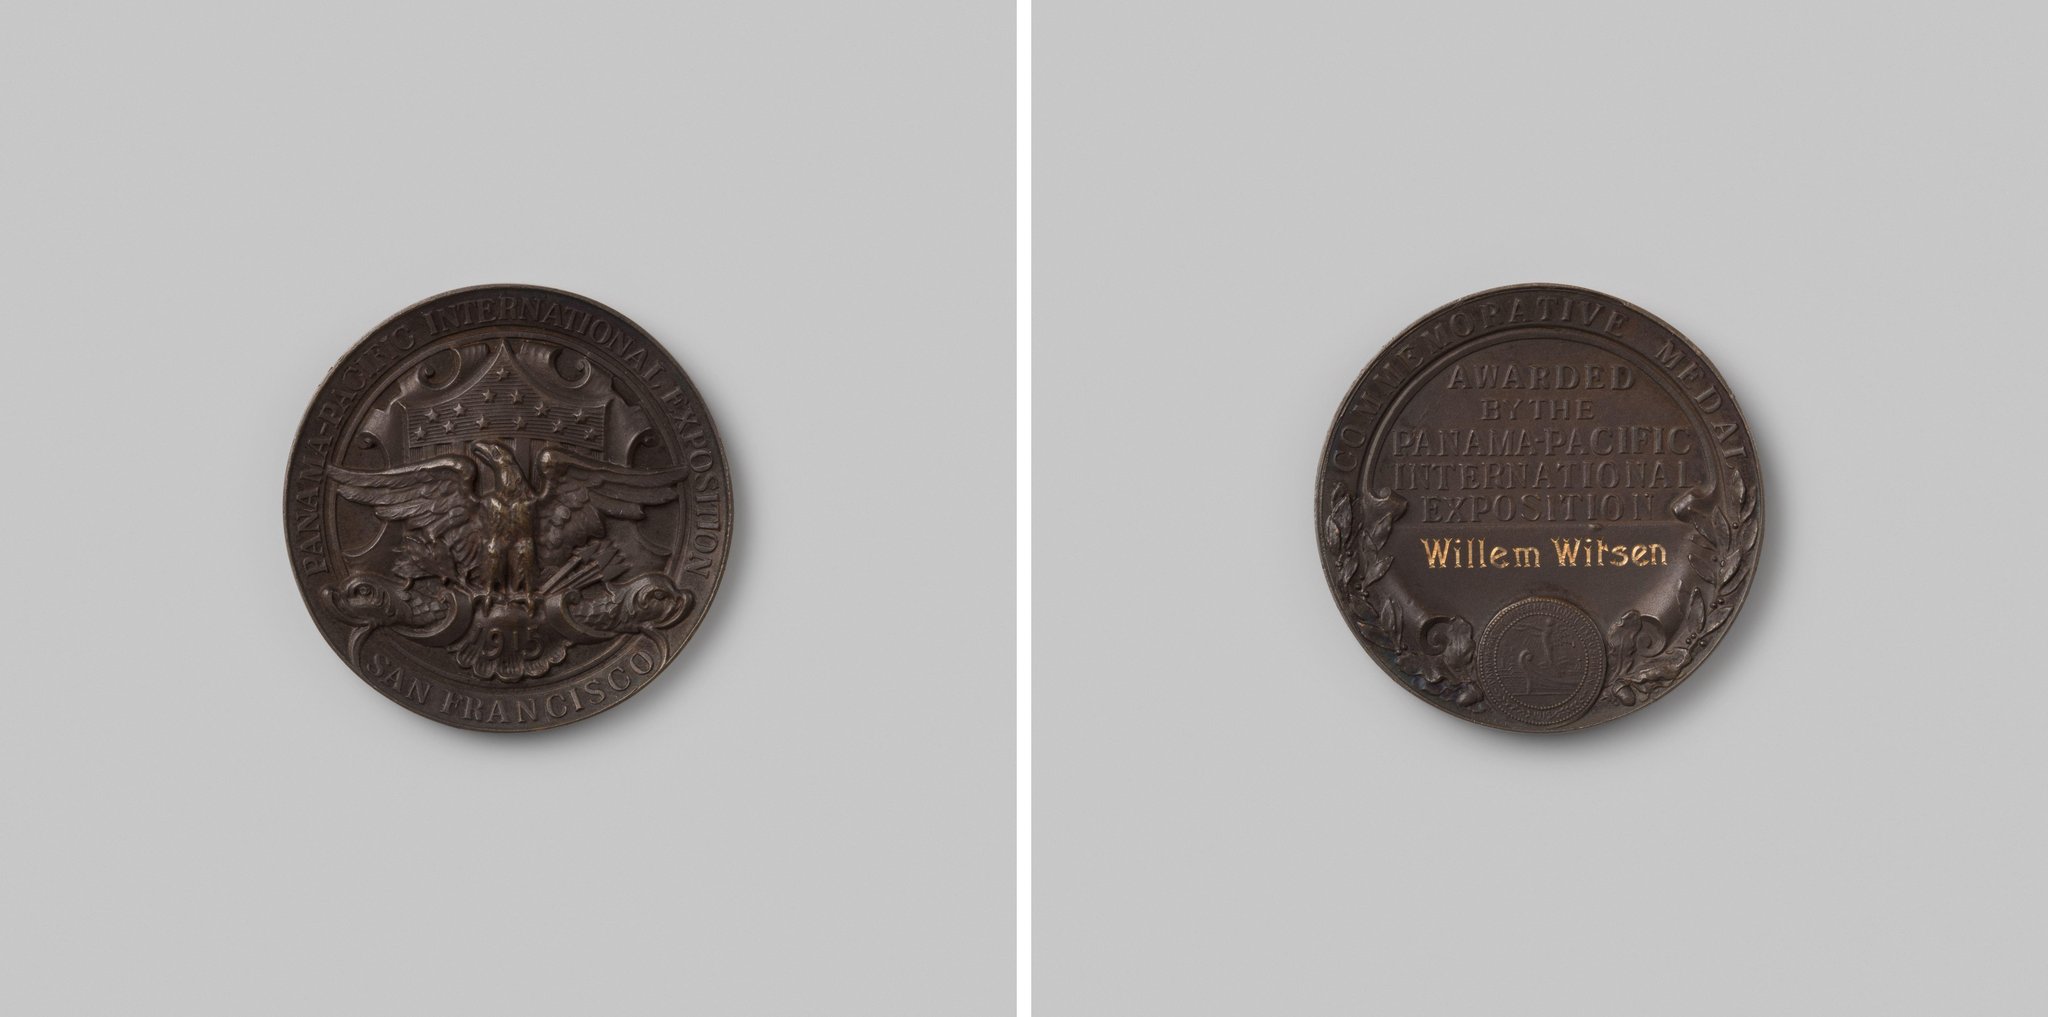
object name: medal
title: Panama-Pacific International Exposition te San Francisco, penning uitgereikt aan Willem Witsen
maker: Anonymous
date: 1915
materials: bronze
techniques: engraving, gilding, striking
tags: amsterdam, painter, print maker, draughtsman, willem witsen, world fair, world exhibition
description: Bronzen penning. Voorzijde: adelaar met tak en pijlen in klauwen, zittend op stronk hout voor wapenschild, in cartouche, boven cartouche met jaartal binnen omschrift. Keerzijde: opschrift in cartouche, boven medaillon met omschrift, rustend op twee lauwertakken binnen omschrift.